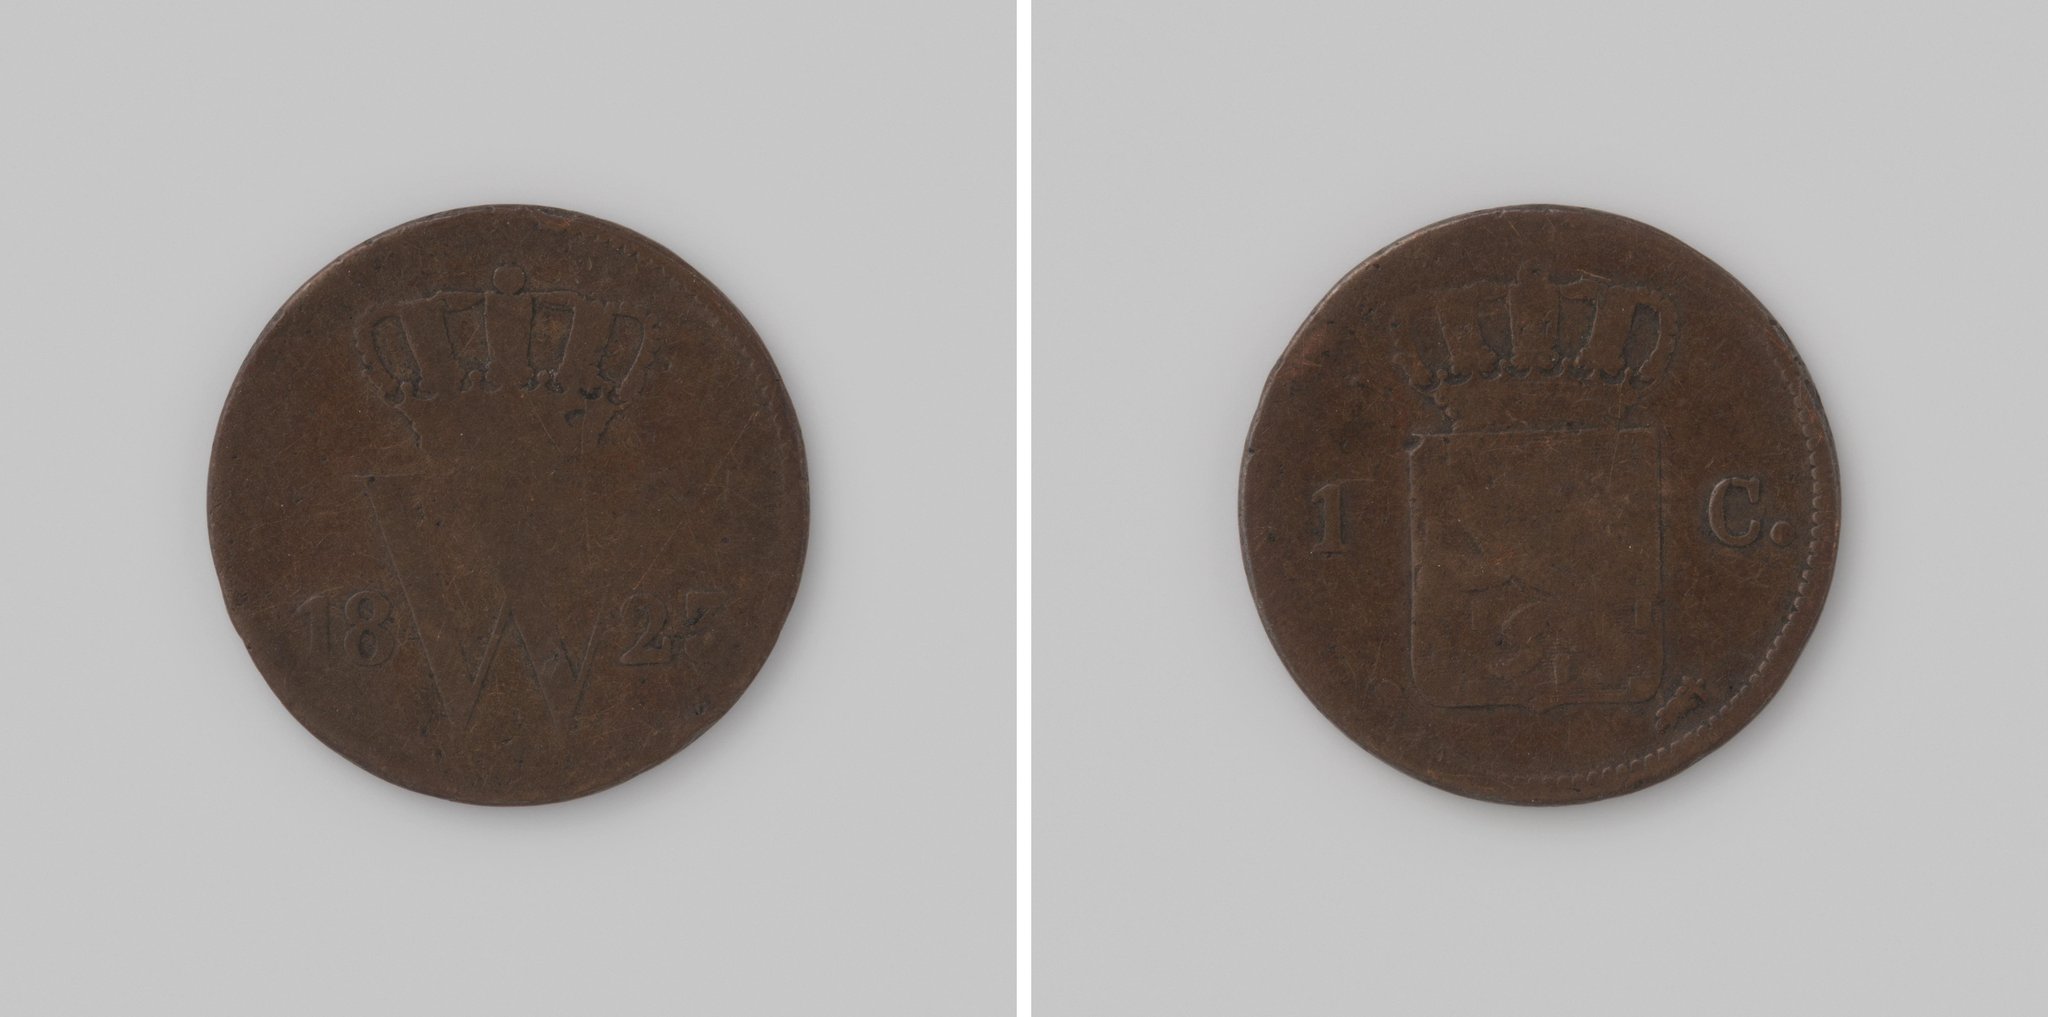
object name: coin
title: 1 cent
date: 1823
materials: copper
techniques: striking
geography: utrecht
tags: william i of the netherlands